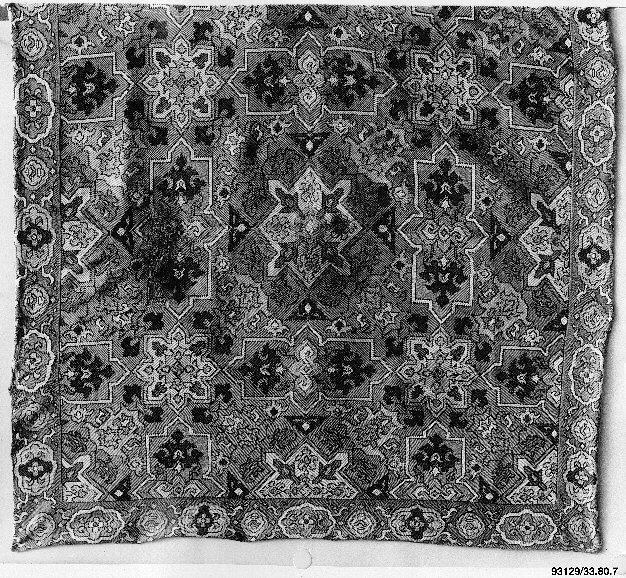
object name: cover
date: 1701-1800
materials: linen, silk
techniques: embroidery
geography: iran